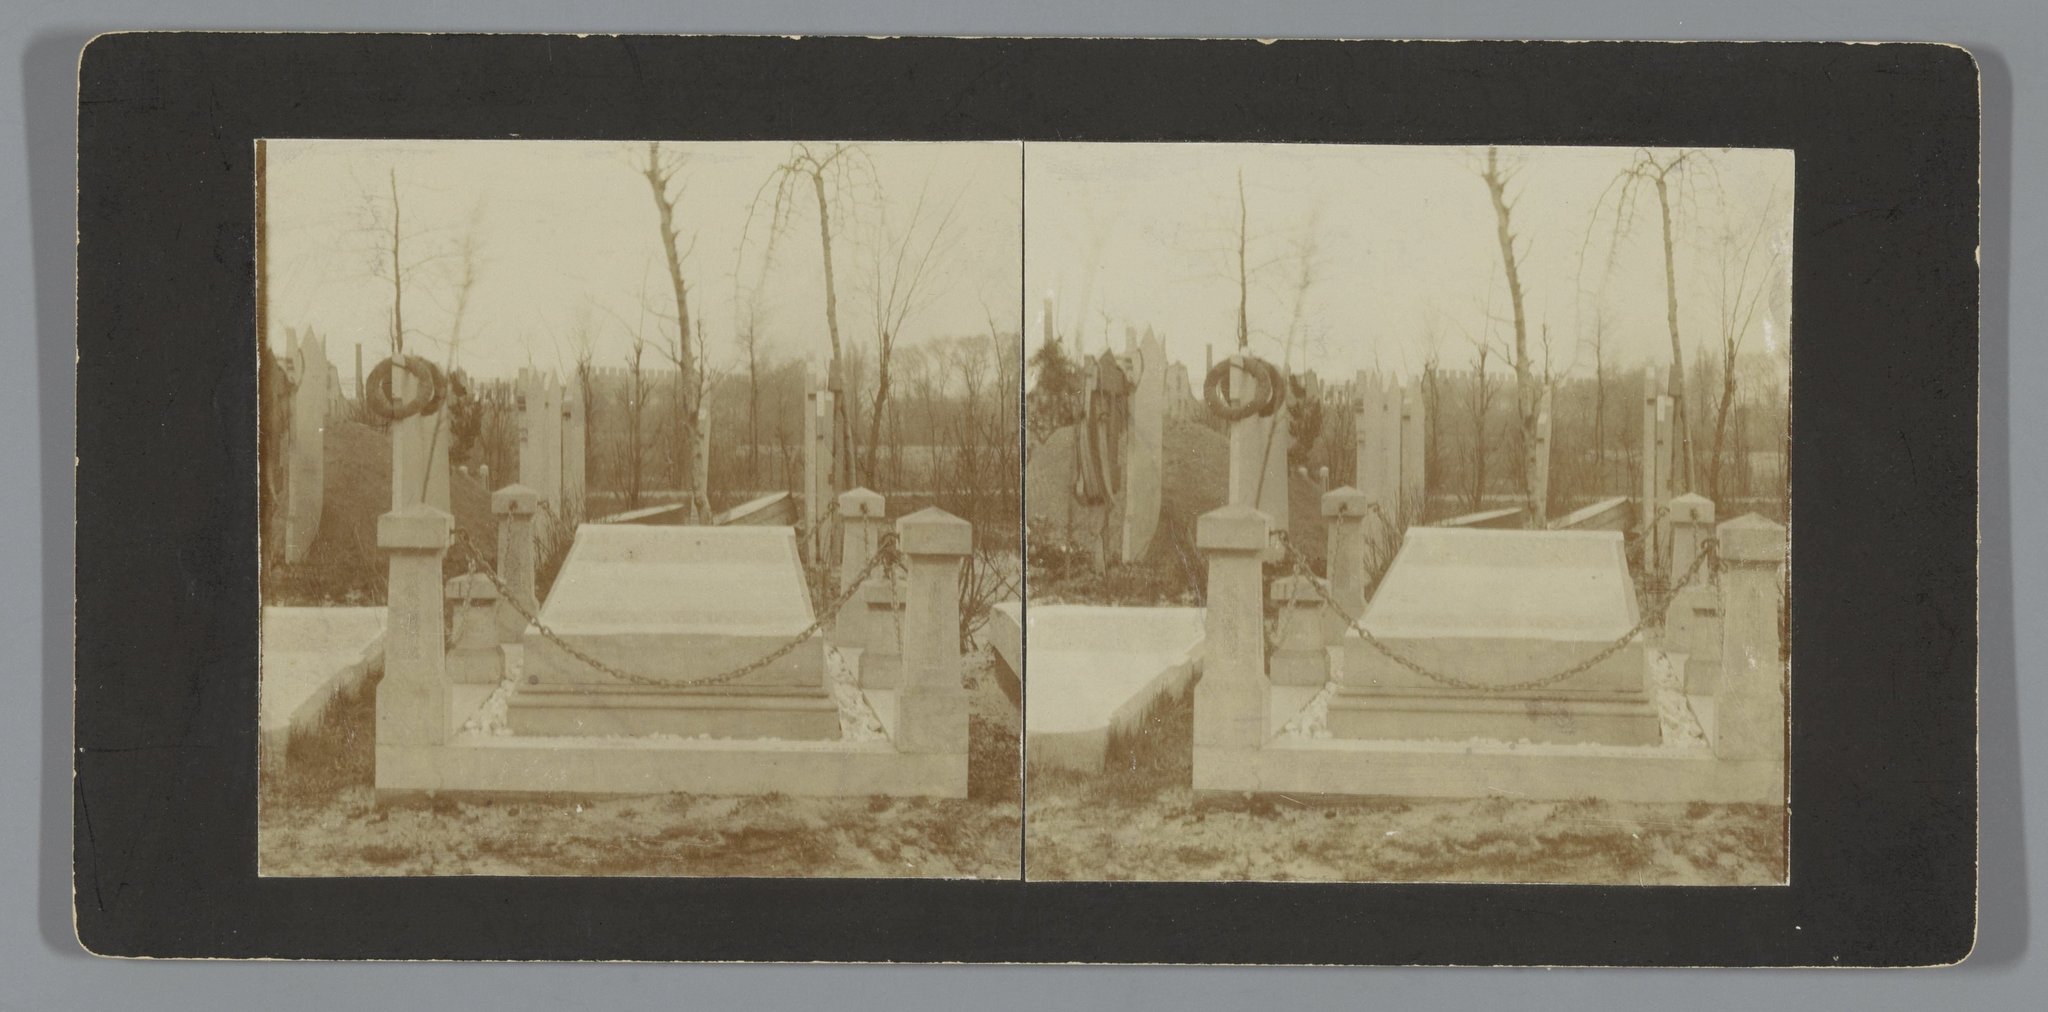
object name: stereograph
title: Graf op een begraafplaats in Nederland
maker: Anonymous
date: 1880-1920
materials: paper, cardboard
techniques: collodion silver print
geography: netherlands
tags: cemetery, park-like burying ground, netherlands